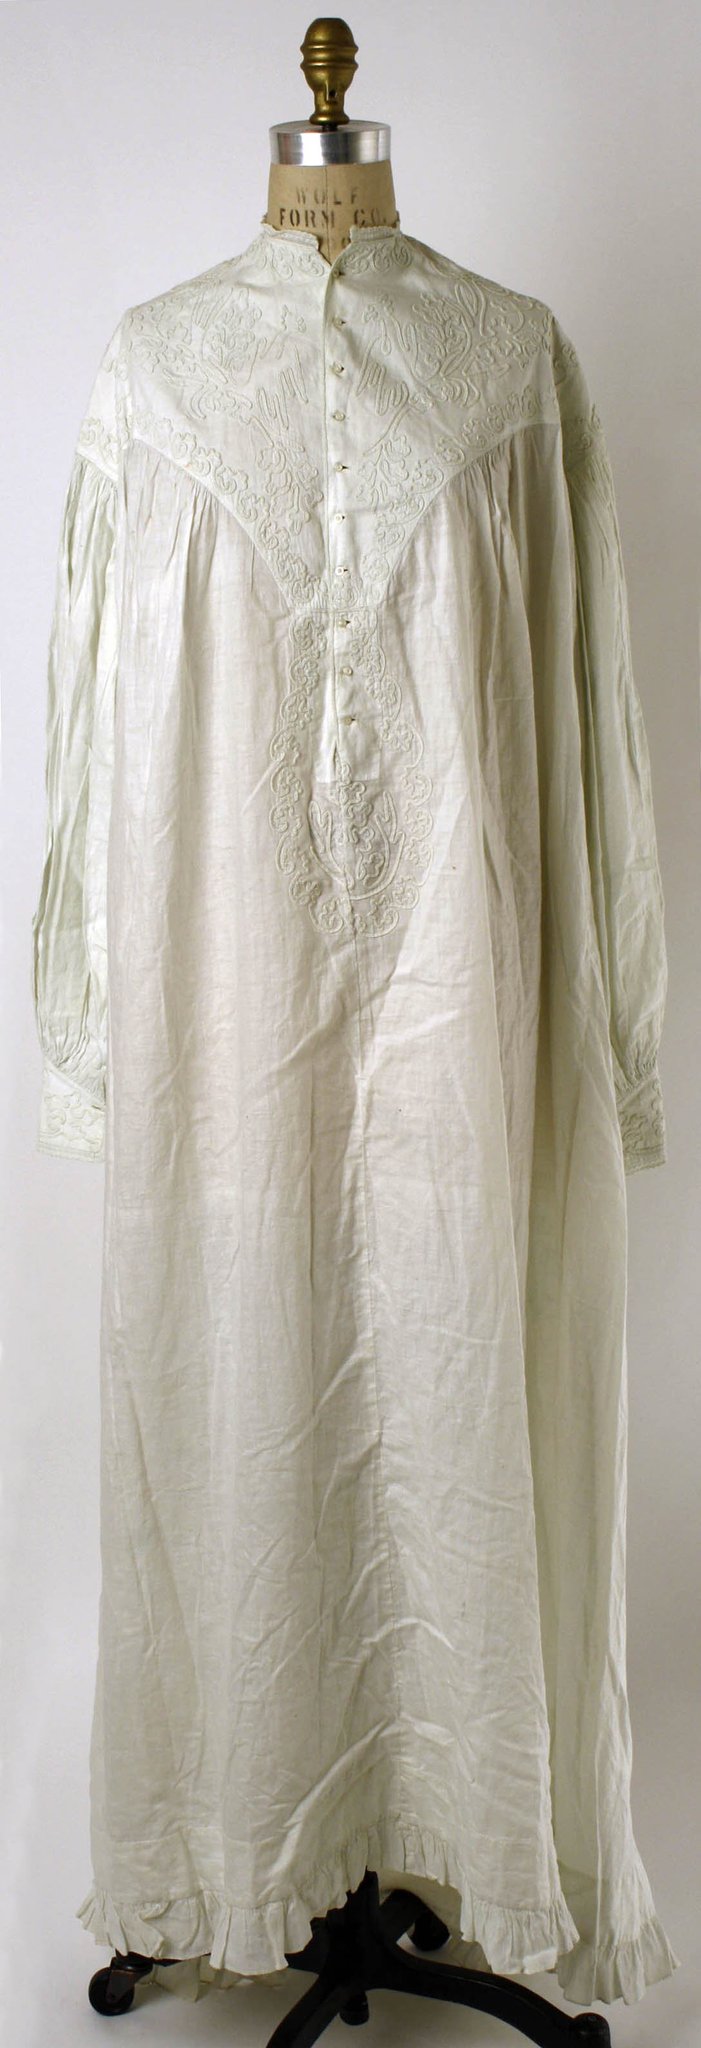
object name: nightgown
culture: french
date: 1860-1869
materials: cotton